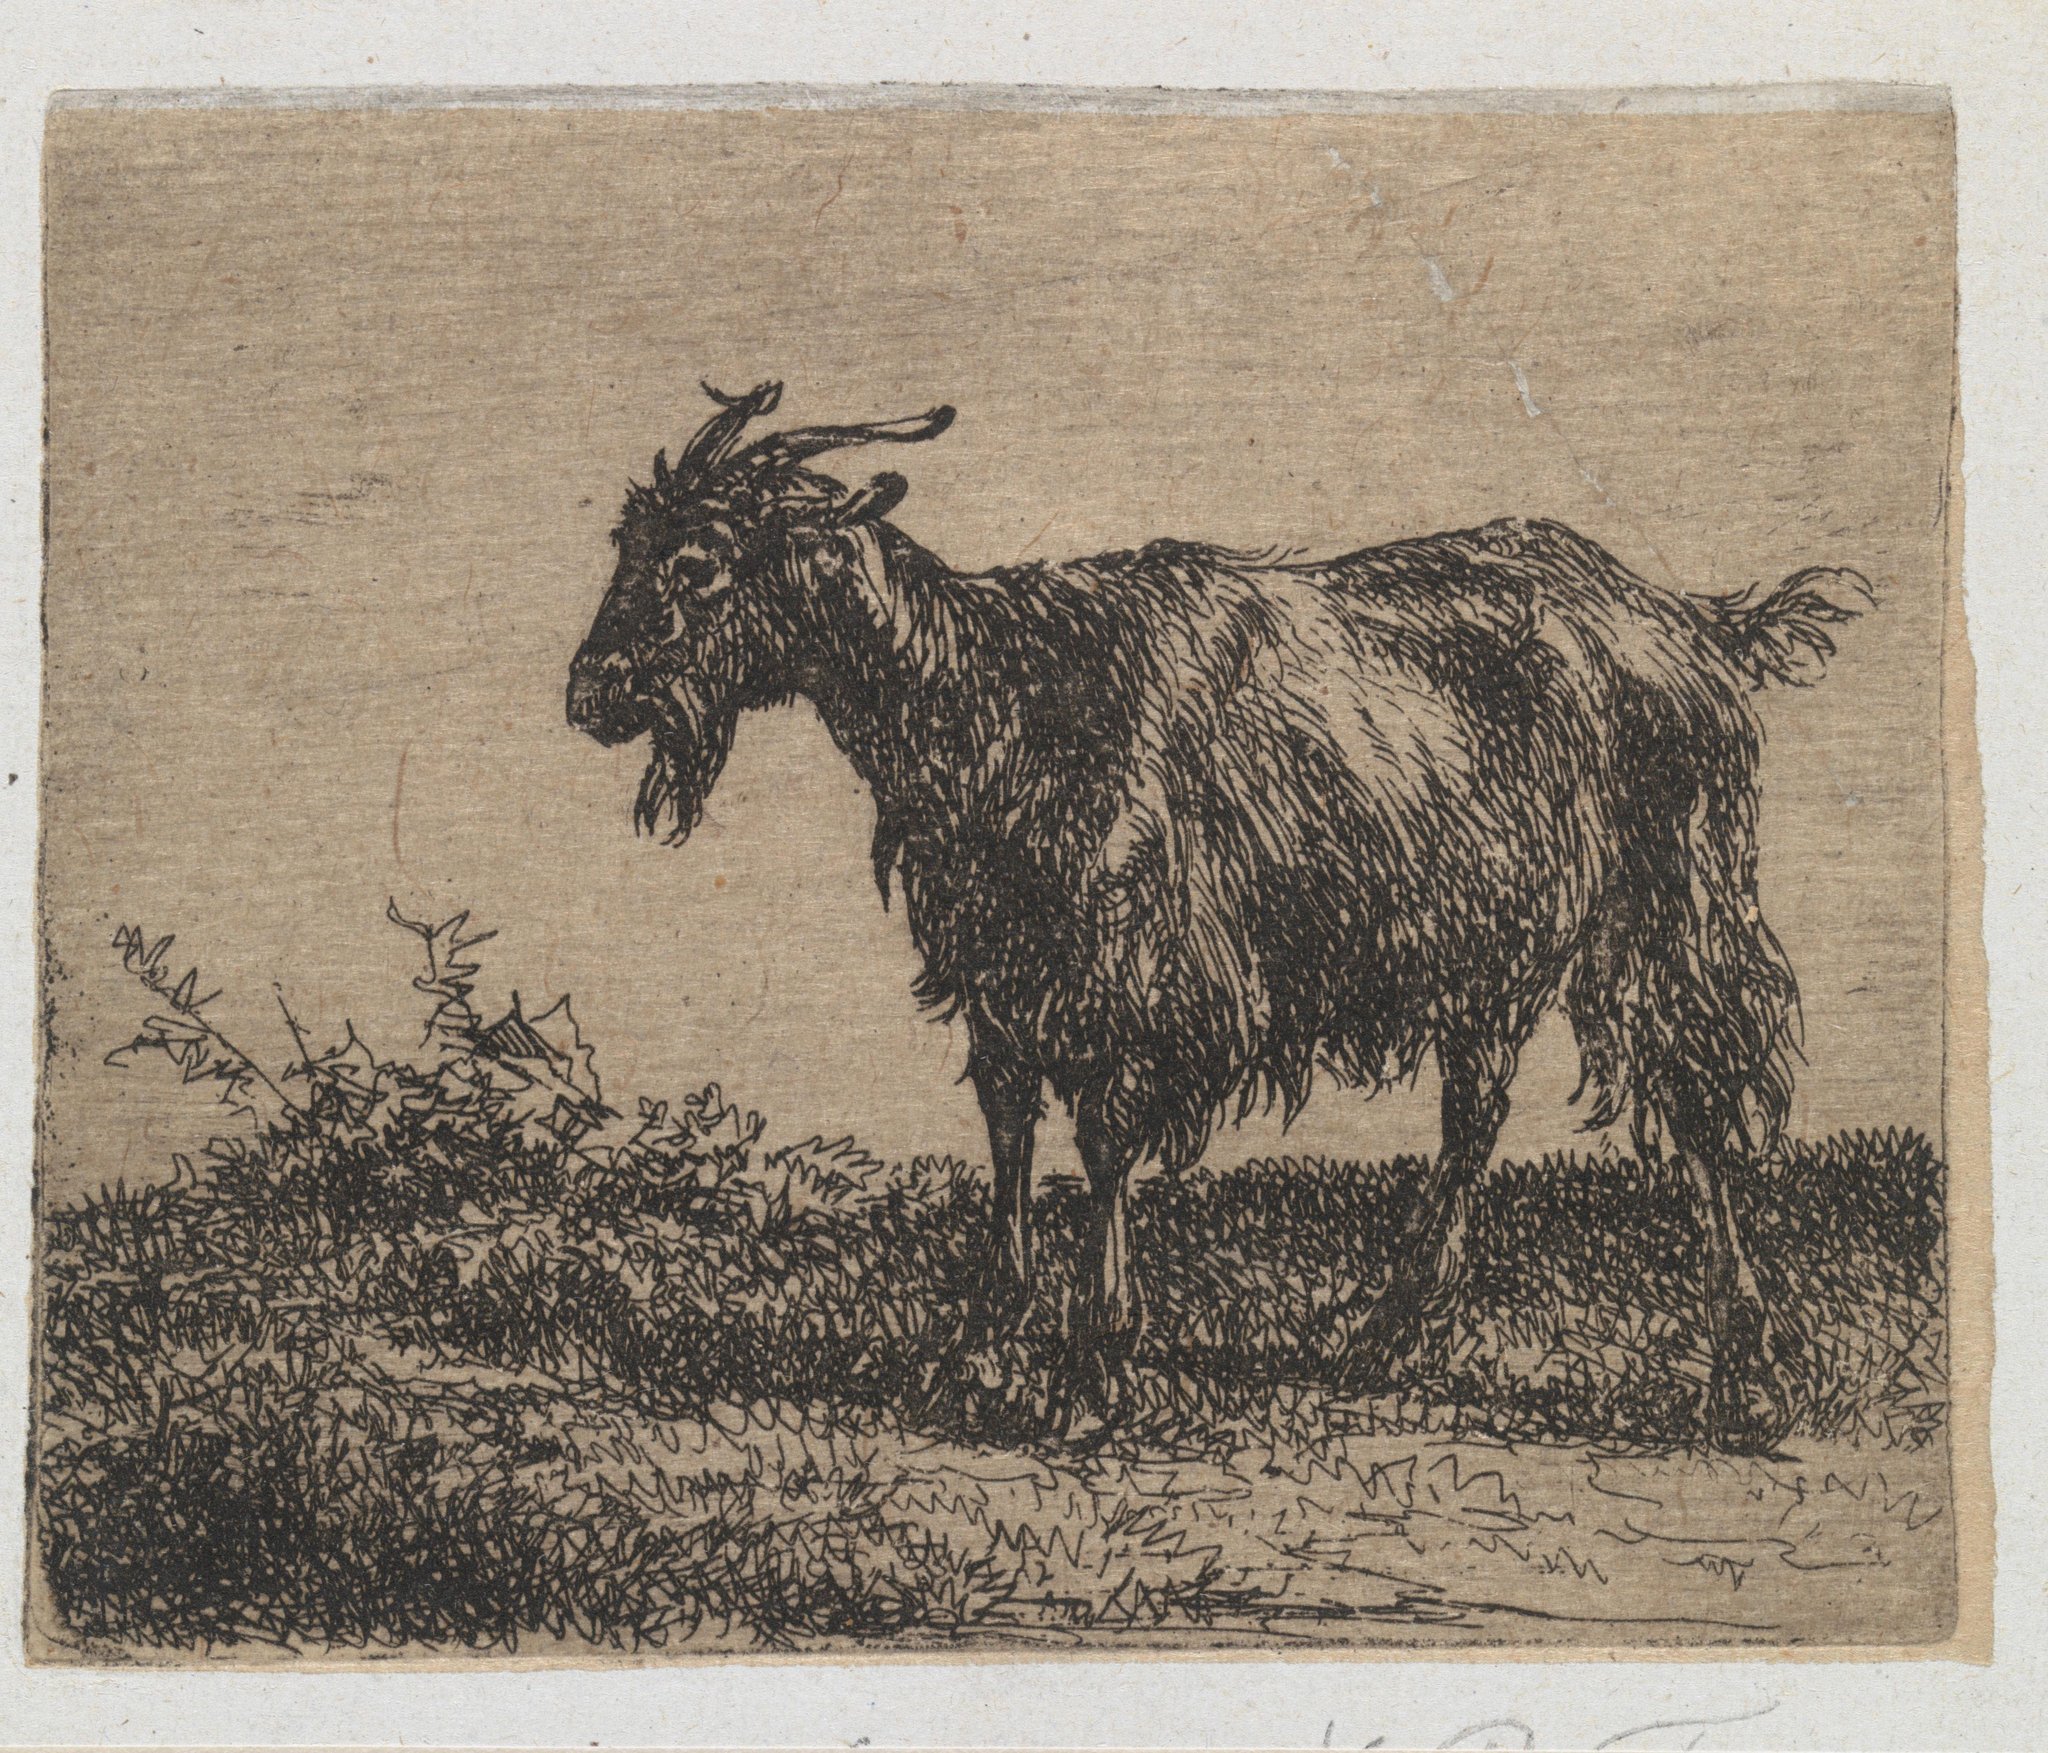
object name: print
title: Geit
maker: jan bedijs tom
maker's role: draughtsman, painter, print maker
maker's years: 1813-1894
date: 1823-1882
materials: paper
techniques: etching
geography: the hague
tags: goat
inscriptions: collector's mark: Lugt 2228